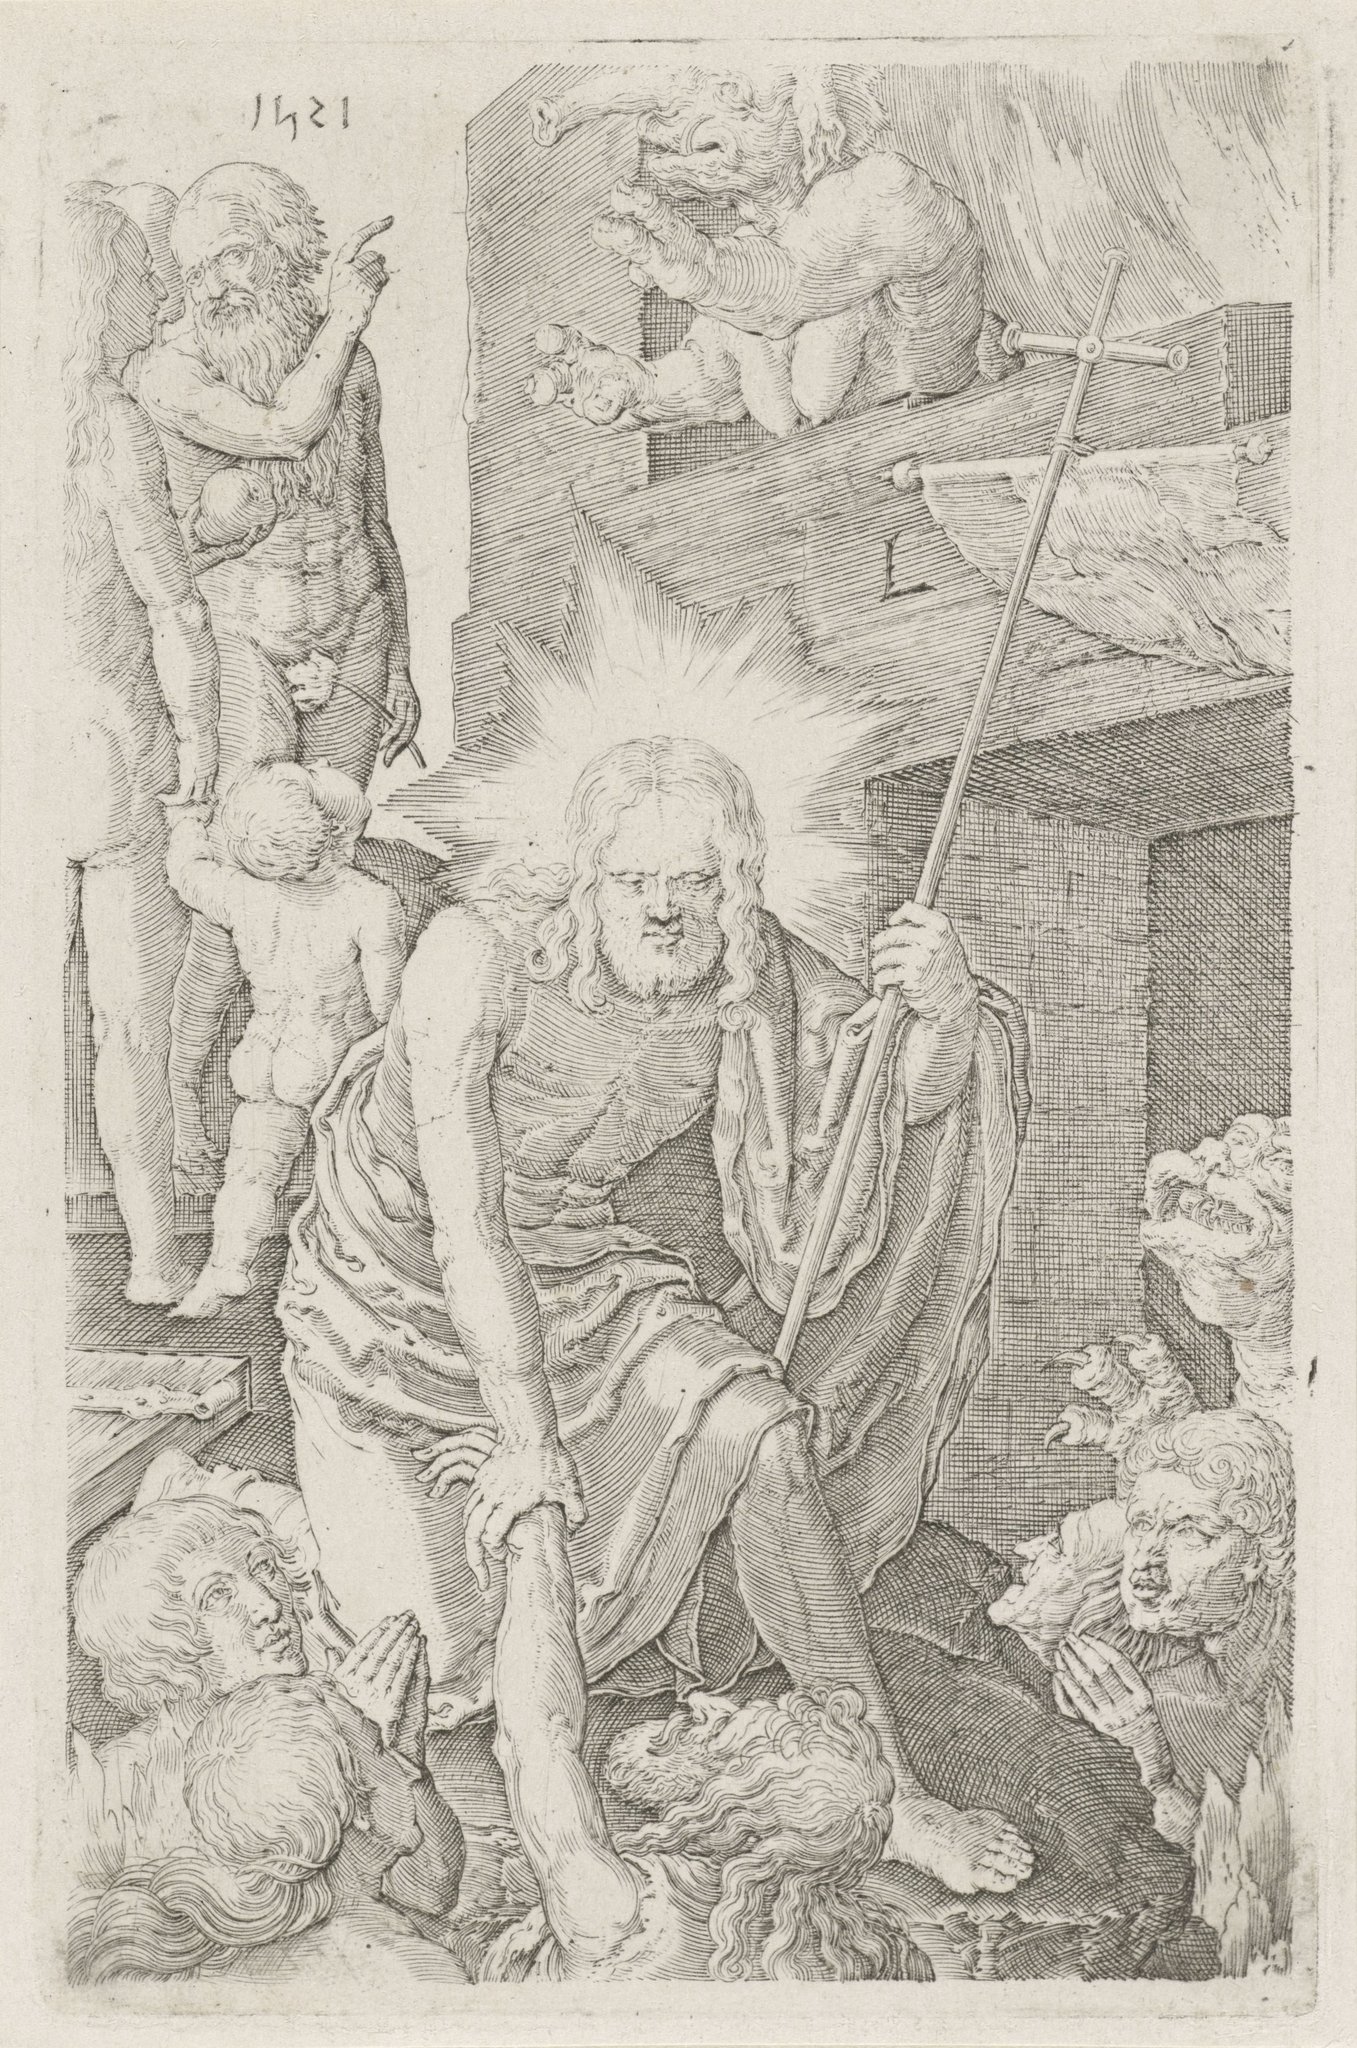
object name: print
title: Passie van Christus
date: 1613-1622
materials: paper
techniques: engraving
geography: amsterdam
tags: christ in the underworld, harrowing of hell, christ in limbo, 'descensus ad inferos', 'anastasis'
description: De serie is in de negentiende eeuw herdrukt met de titel: Die Leiden Christi. La Passion de Jesus-Christ. 14 Blatt. Nach Lucas von Leyden in Kupfer gestochen von J. Müller. Wellicht een reproductie?